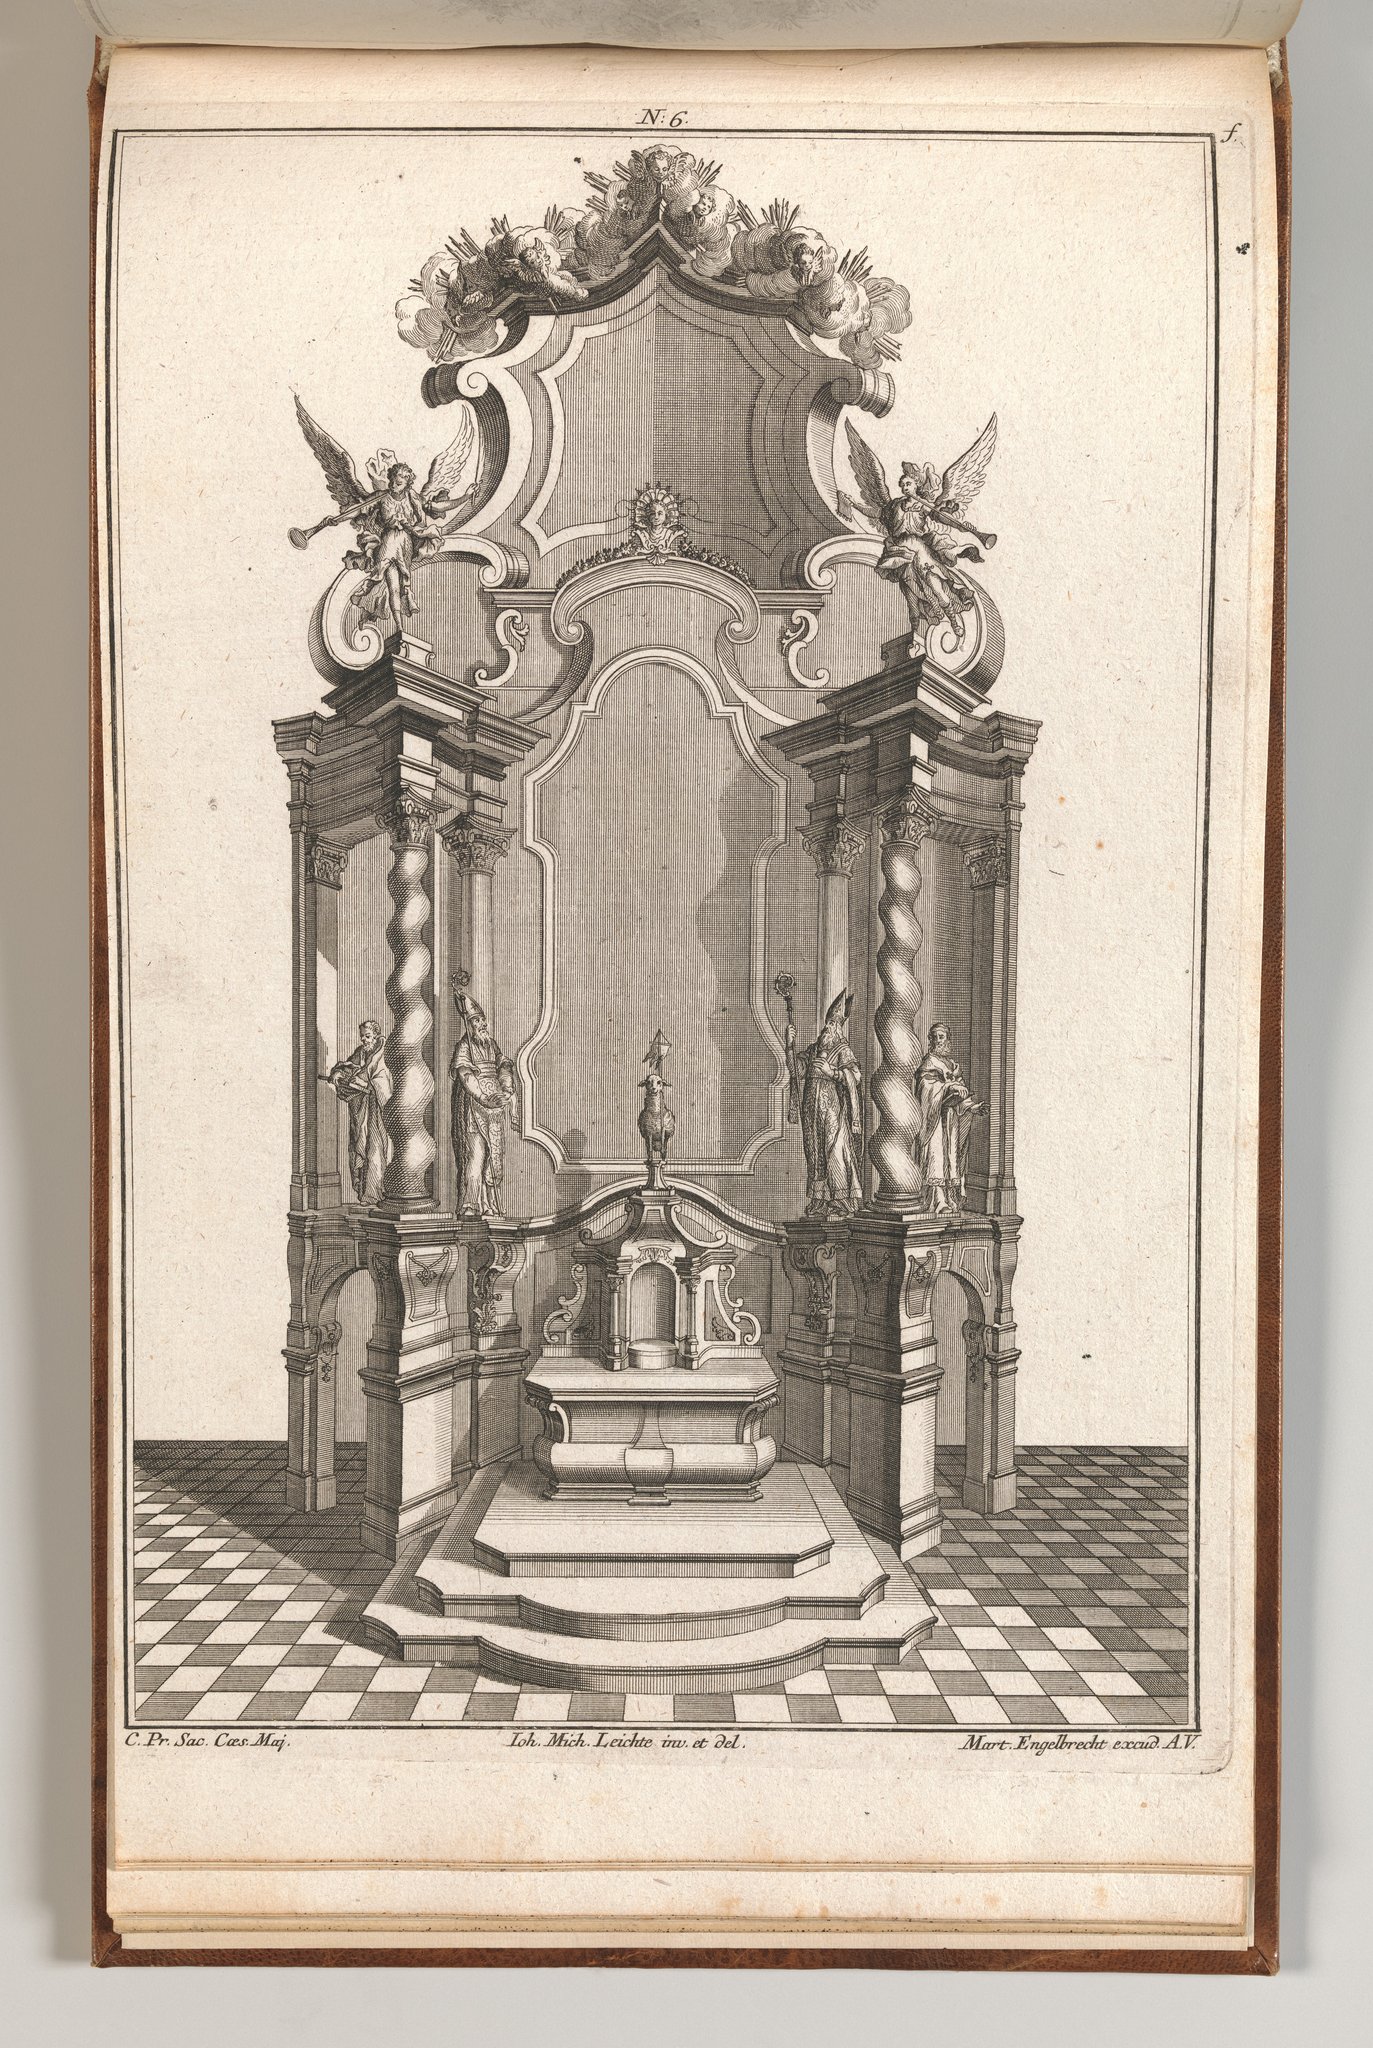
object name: album print ornament architecture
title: Design for a Monumental Altar, Plate f from 'Unterschiedliche Neu Inventierte Altäre mit darzu gehörigen Profillen u. Grundrißen.'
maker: johann michael leüchte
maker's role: artist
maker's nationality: german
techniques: etching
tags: altars,men,lambs